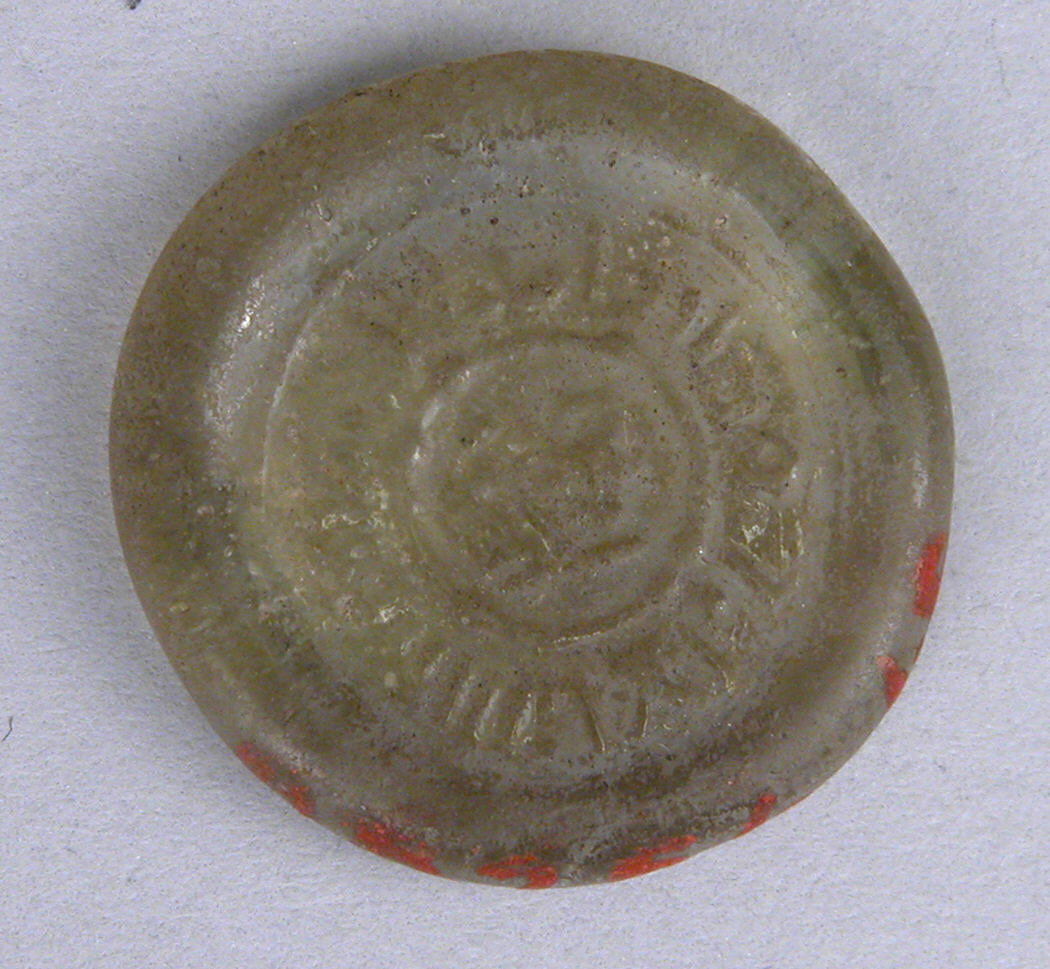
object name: coin weight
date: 1001-1100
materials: glass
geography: egypt